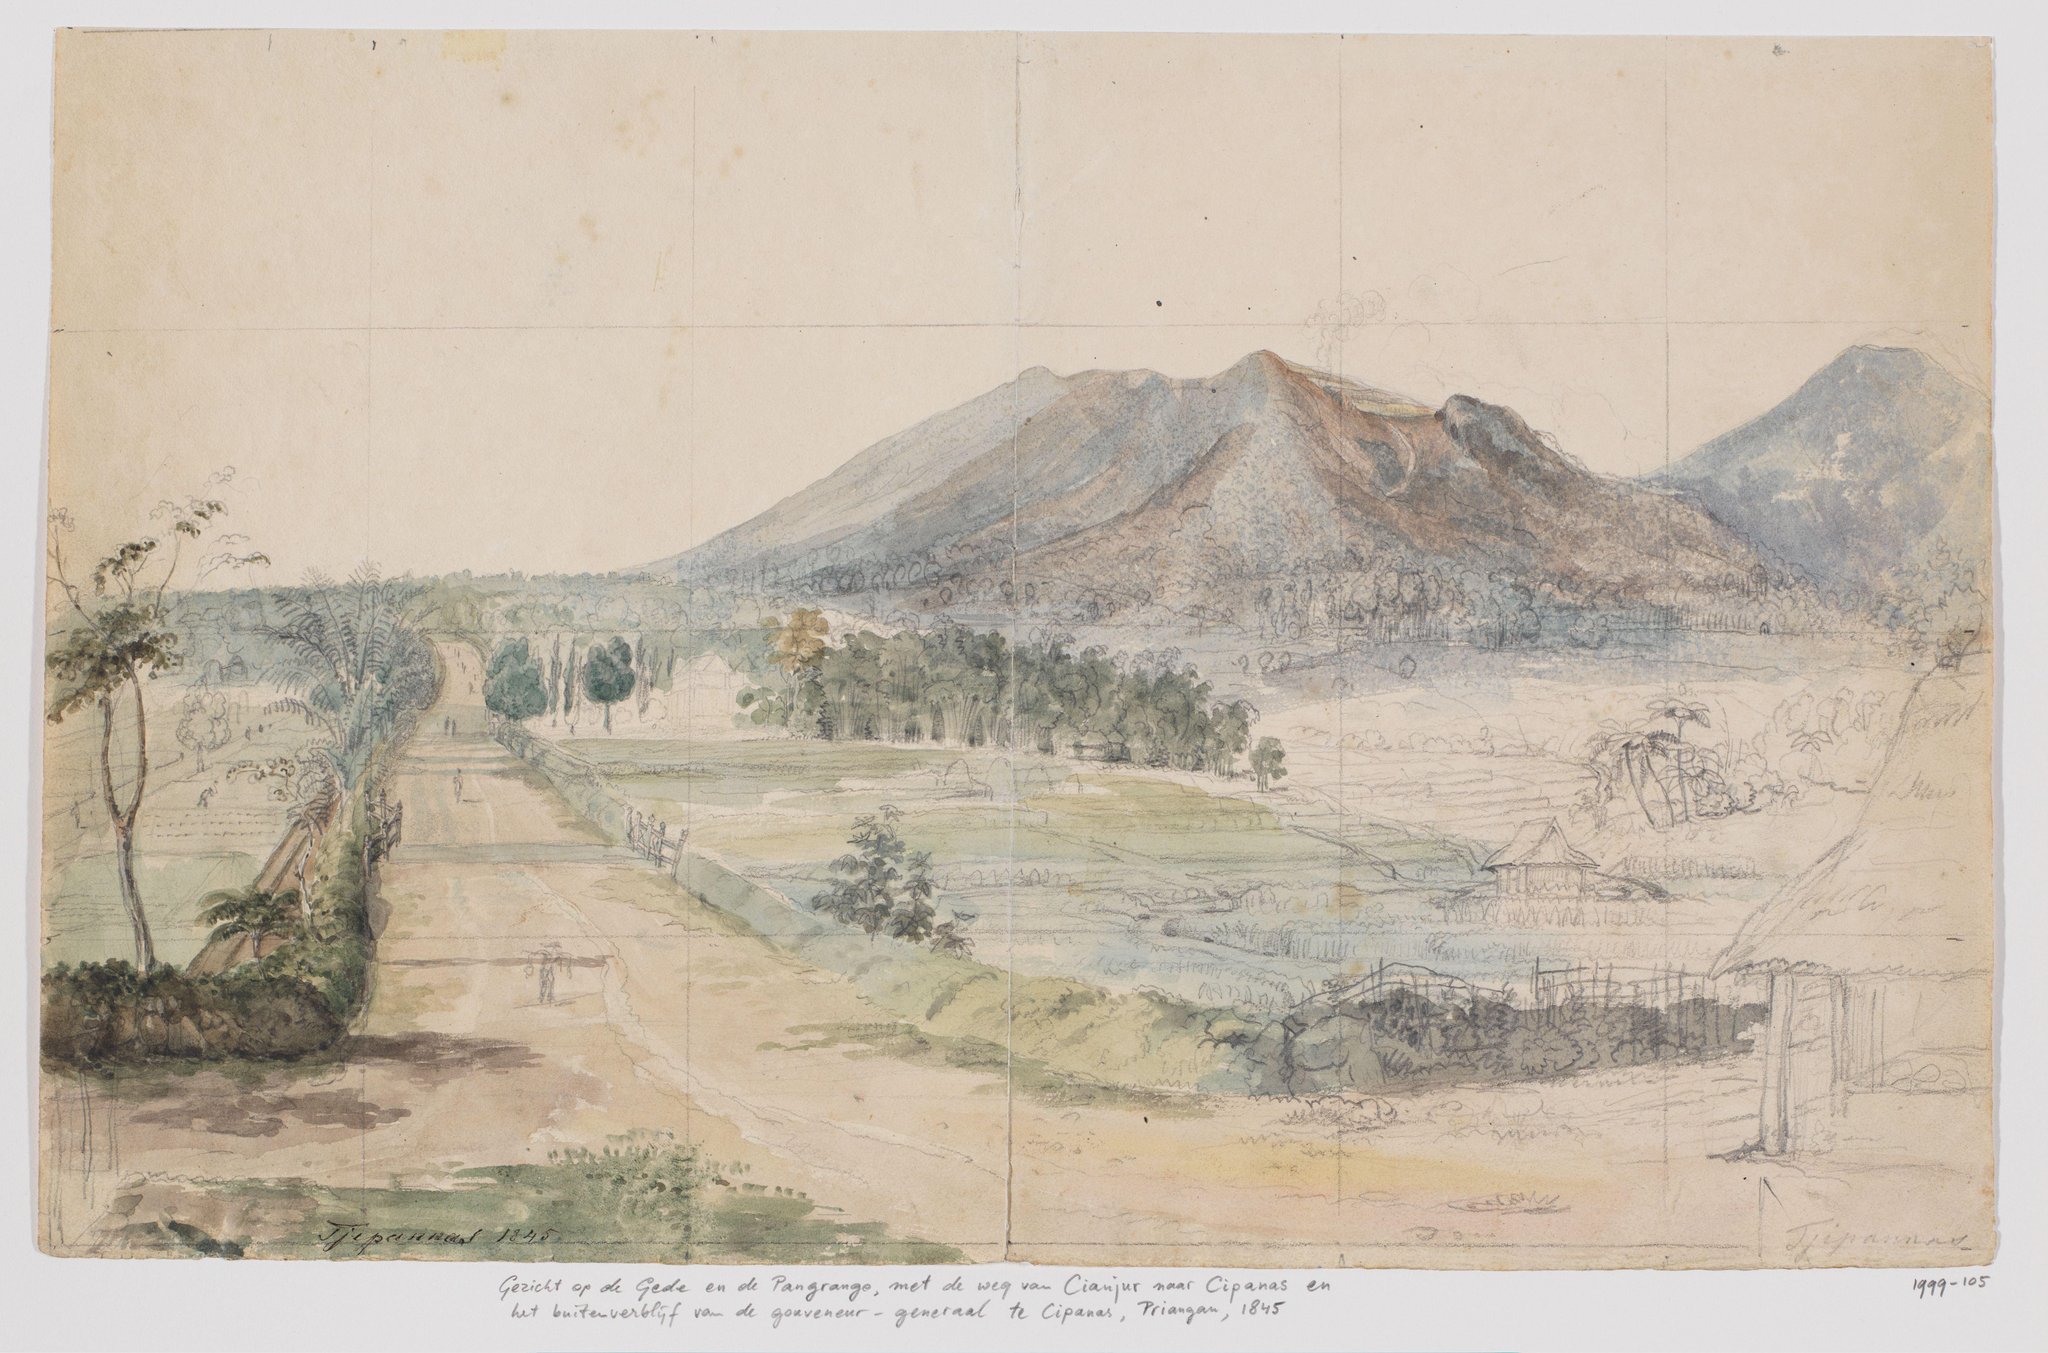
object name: drawing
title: Gezicht op de vulkanen Gedé en Pangrango, weg Cianjur-Cipanas en buitenverblijf van de gouverneur-generaal te Cipanas, Priangan, West-Java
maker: adrianus johannes bik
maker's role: draughtsman, print maker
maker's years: 1790-1872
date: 1845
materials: ink, paper, pencil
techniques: brush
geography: west java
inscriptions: inscription: ‘Tjipannas 1845; Tjipannas’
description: artikel over deze collectie in Bulletin van het Rijksmuseum 49 [2001], nr. 4, pp 342 e.v.